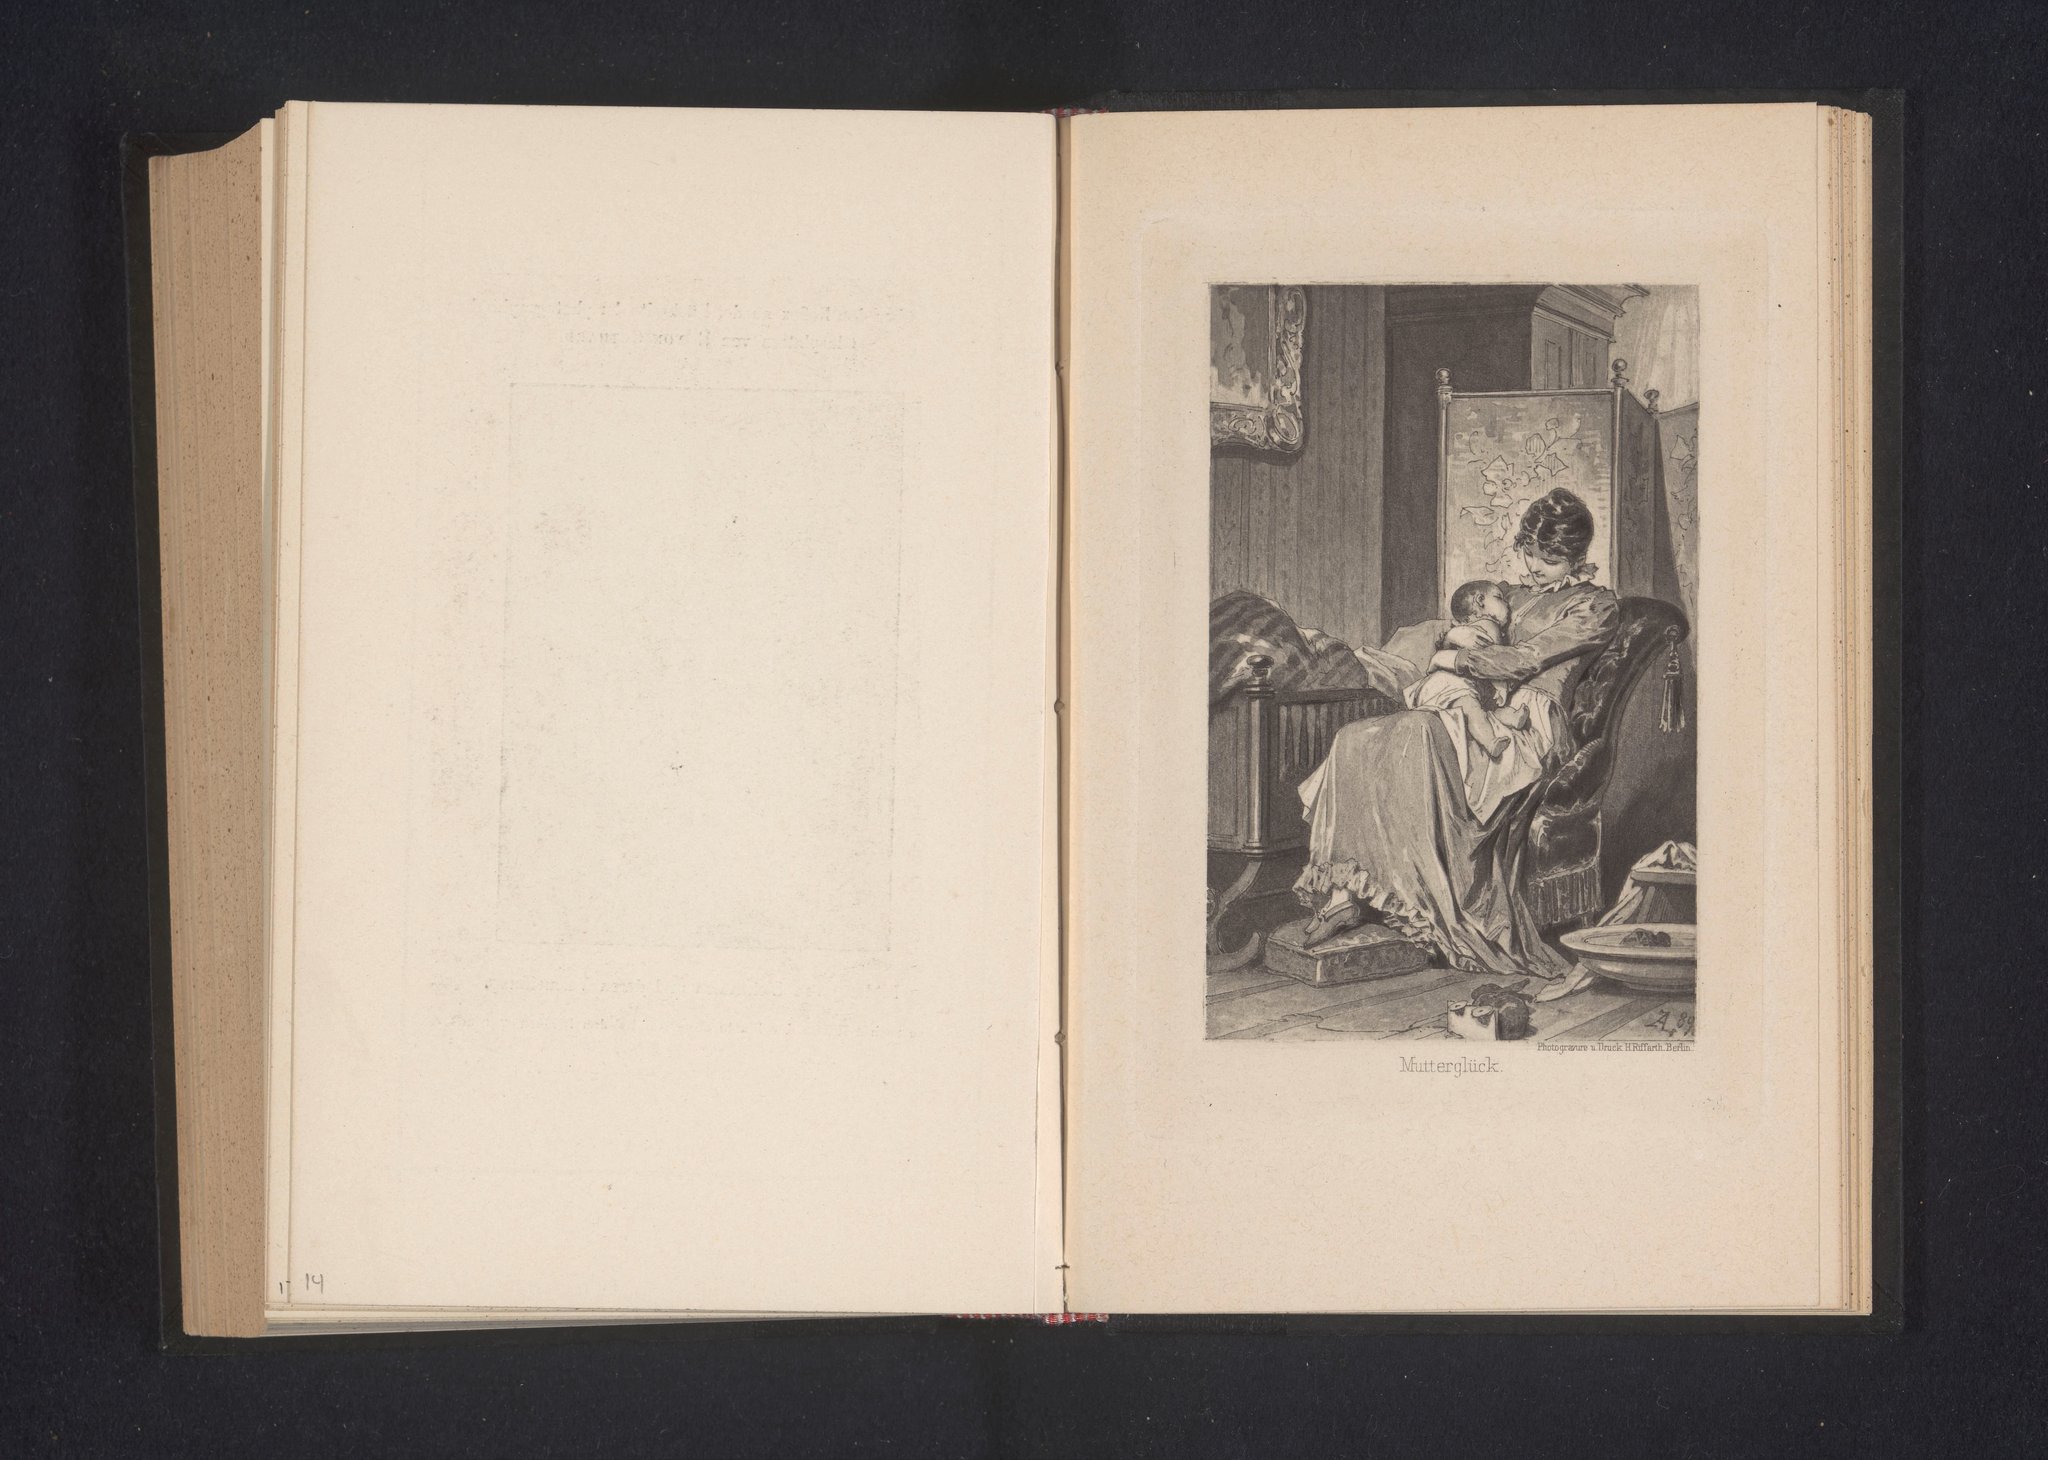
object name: photomechanical print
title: Mutterglück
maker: heinrich riffarth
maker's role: printer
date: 1885-1890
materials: paper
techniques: photoaquatint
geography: berlin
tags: watching a sleeping child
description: Prent op eenendertigste ongenummerde pagina na pagina 400.